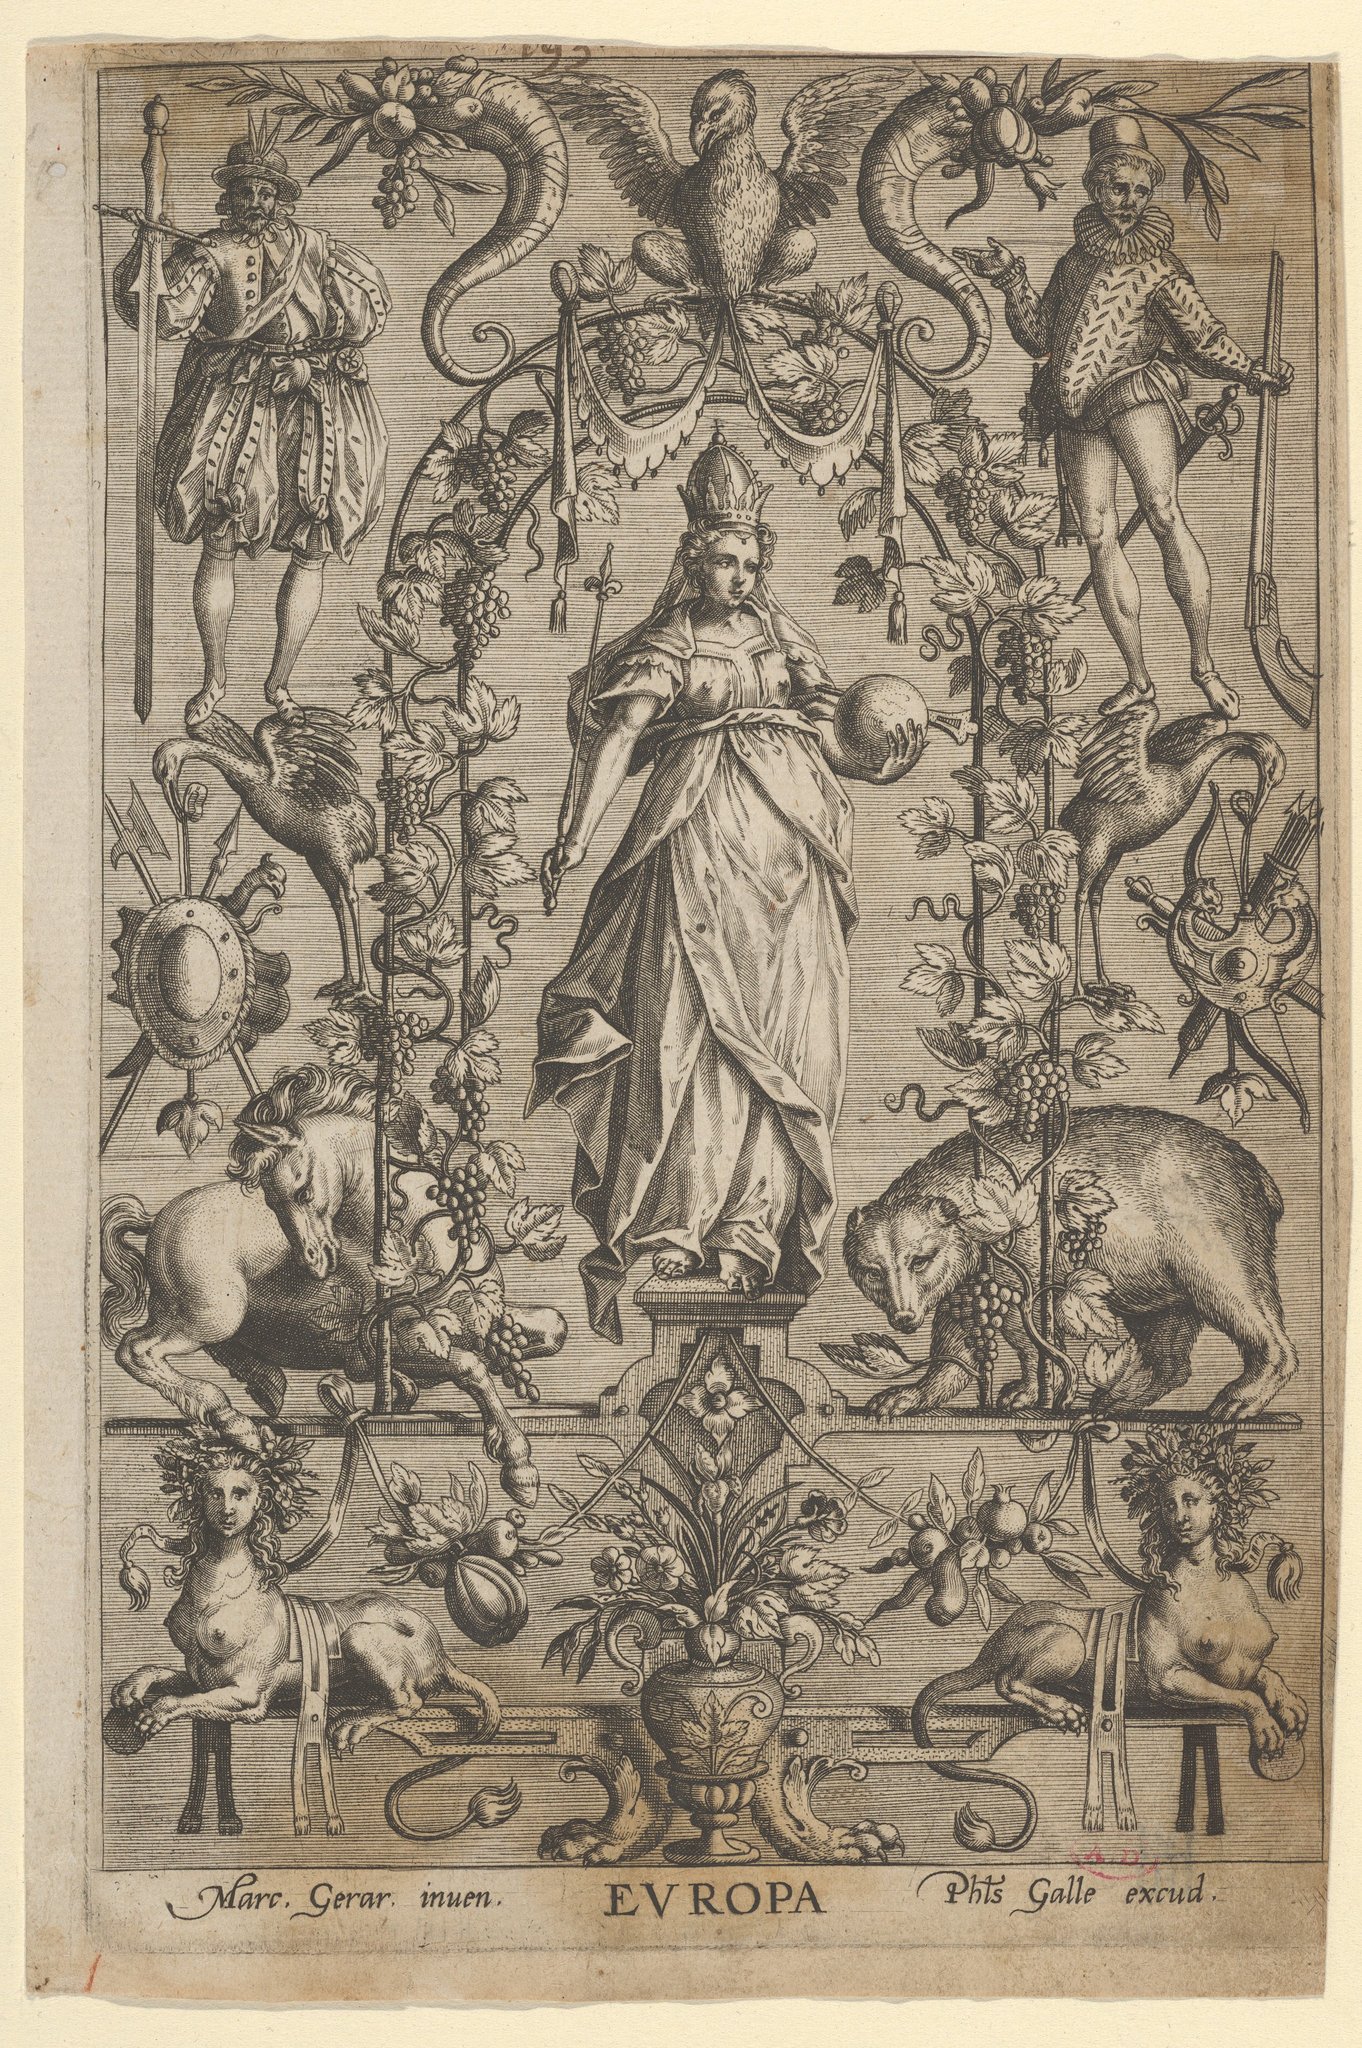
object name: print ornament architecture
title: Allegory of Europe, from "The Four Continents"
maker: marcus gheeraerts the elder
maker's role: artist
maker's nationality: flemish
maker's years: 1510-1600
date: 1590-1600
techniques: engraving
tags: bears,eagles,men,women,horses